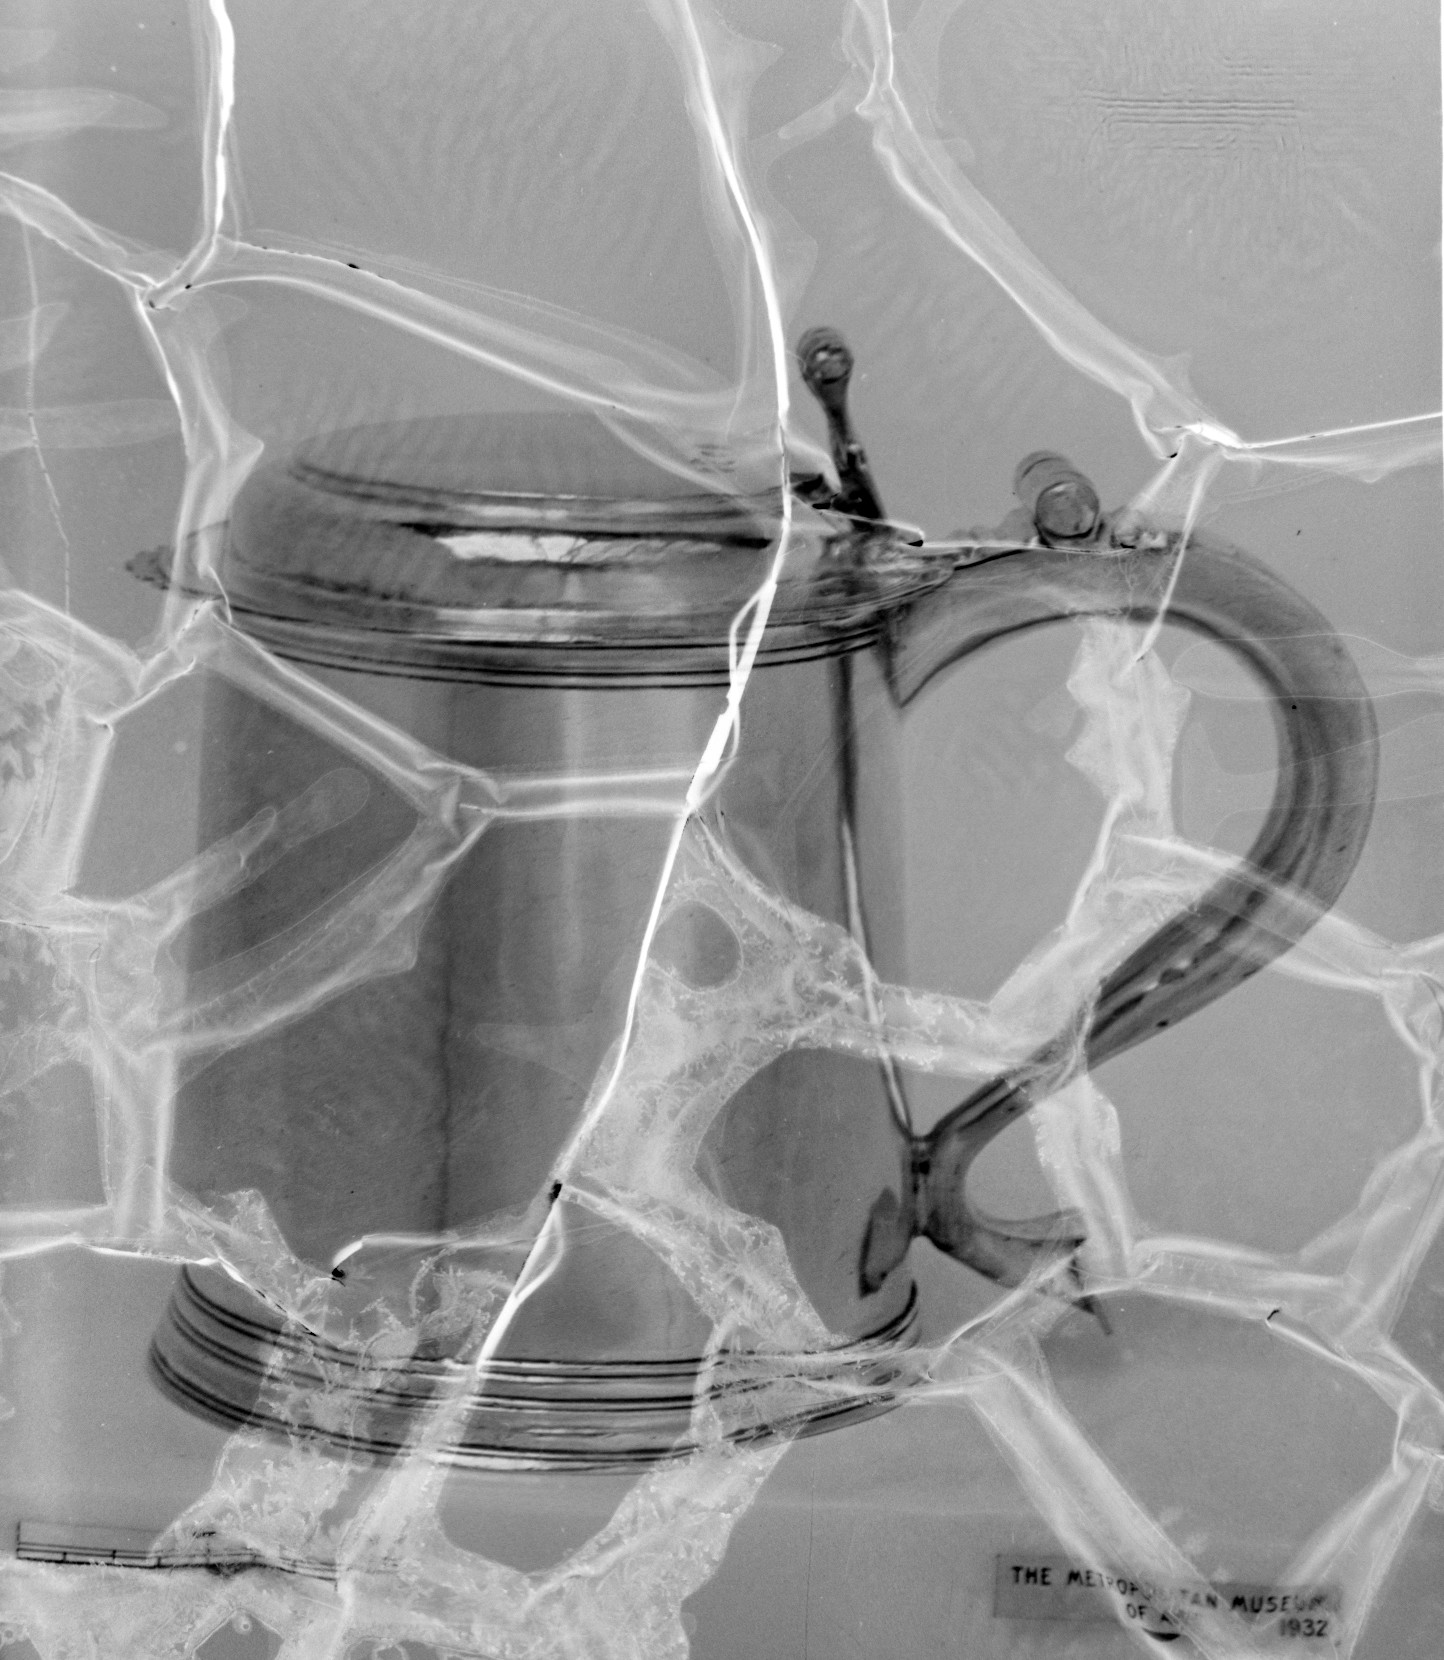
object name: tankard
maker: h. r., london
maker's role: maker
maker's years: 1665-1697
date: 1692-1693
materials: silver